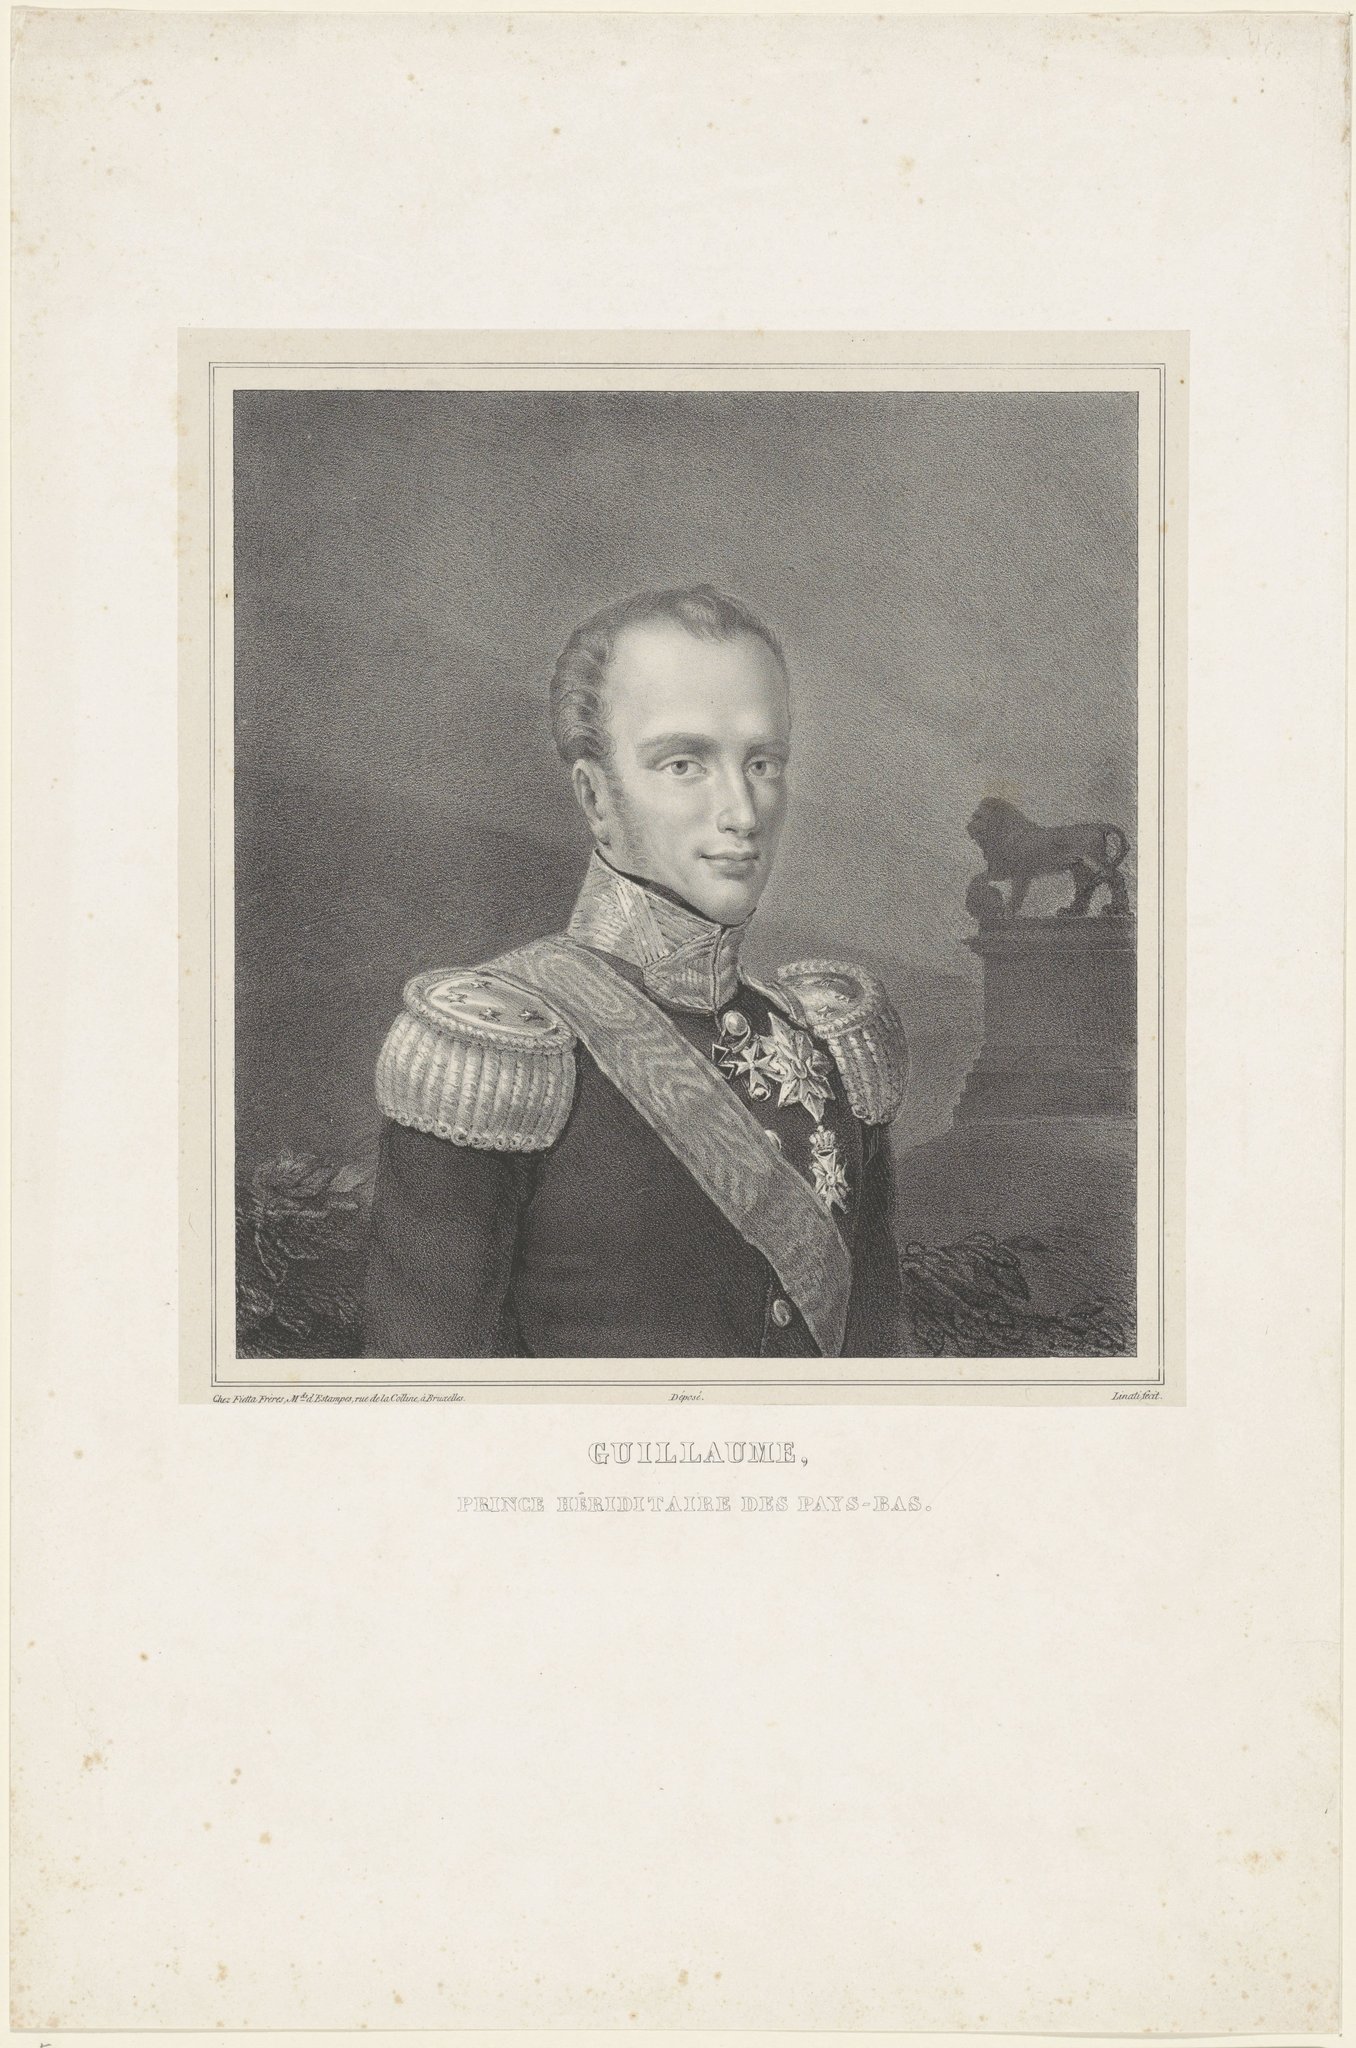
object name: print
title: Portret van Willem II, koning der Nederlanden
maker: claudio linati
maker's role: print maker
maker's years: 1790-1832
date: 1826-1829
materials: paper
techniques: lithograph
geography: brussels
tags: the hague, william ii of the netherlands, piece of sculpture, reproduction of a piece of sculpture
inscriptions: collector's mark: Lugt 963, collector's mark: Lugt 2165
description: De hier vermelde titel verwijst naar de hoogst verkregen titel van de geportretteerde, niet per se naar de titel die de geportretteerde op deze voorstelling draagt.